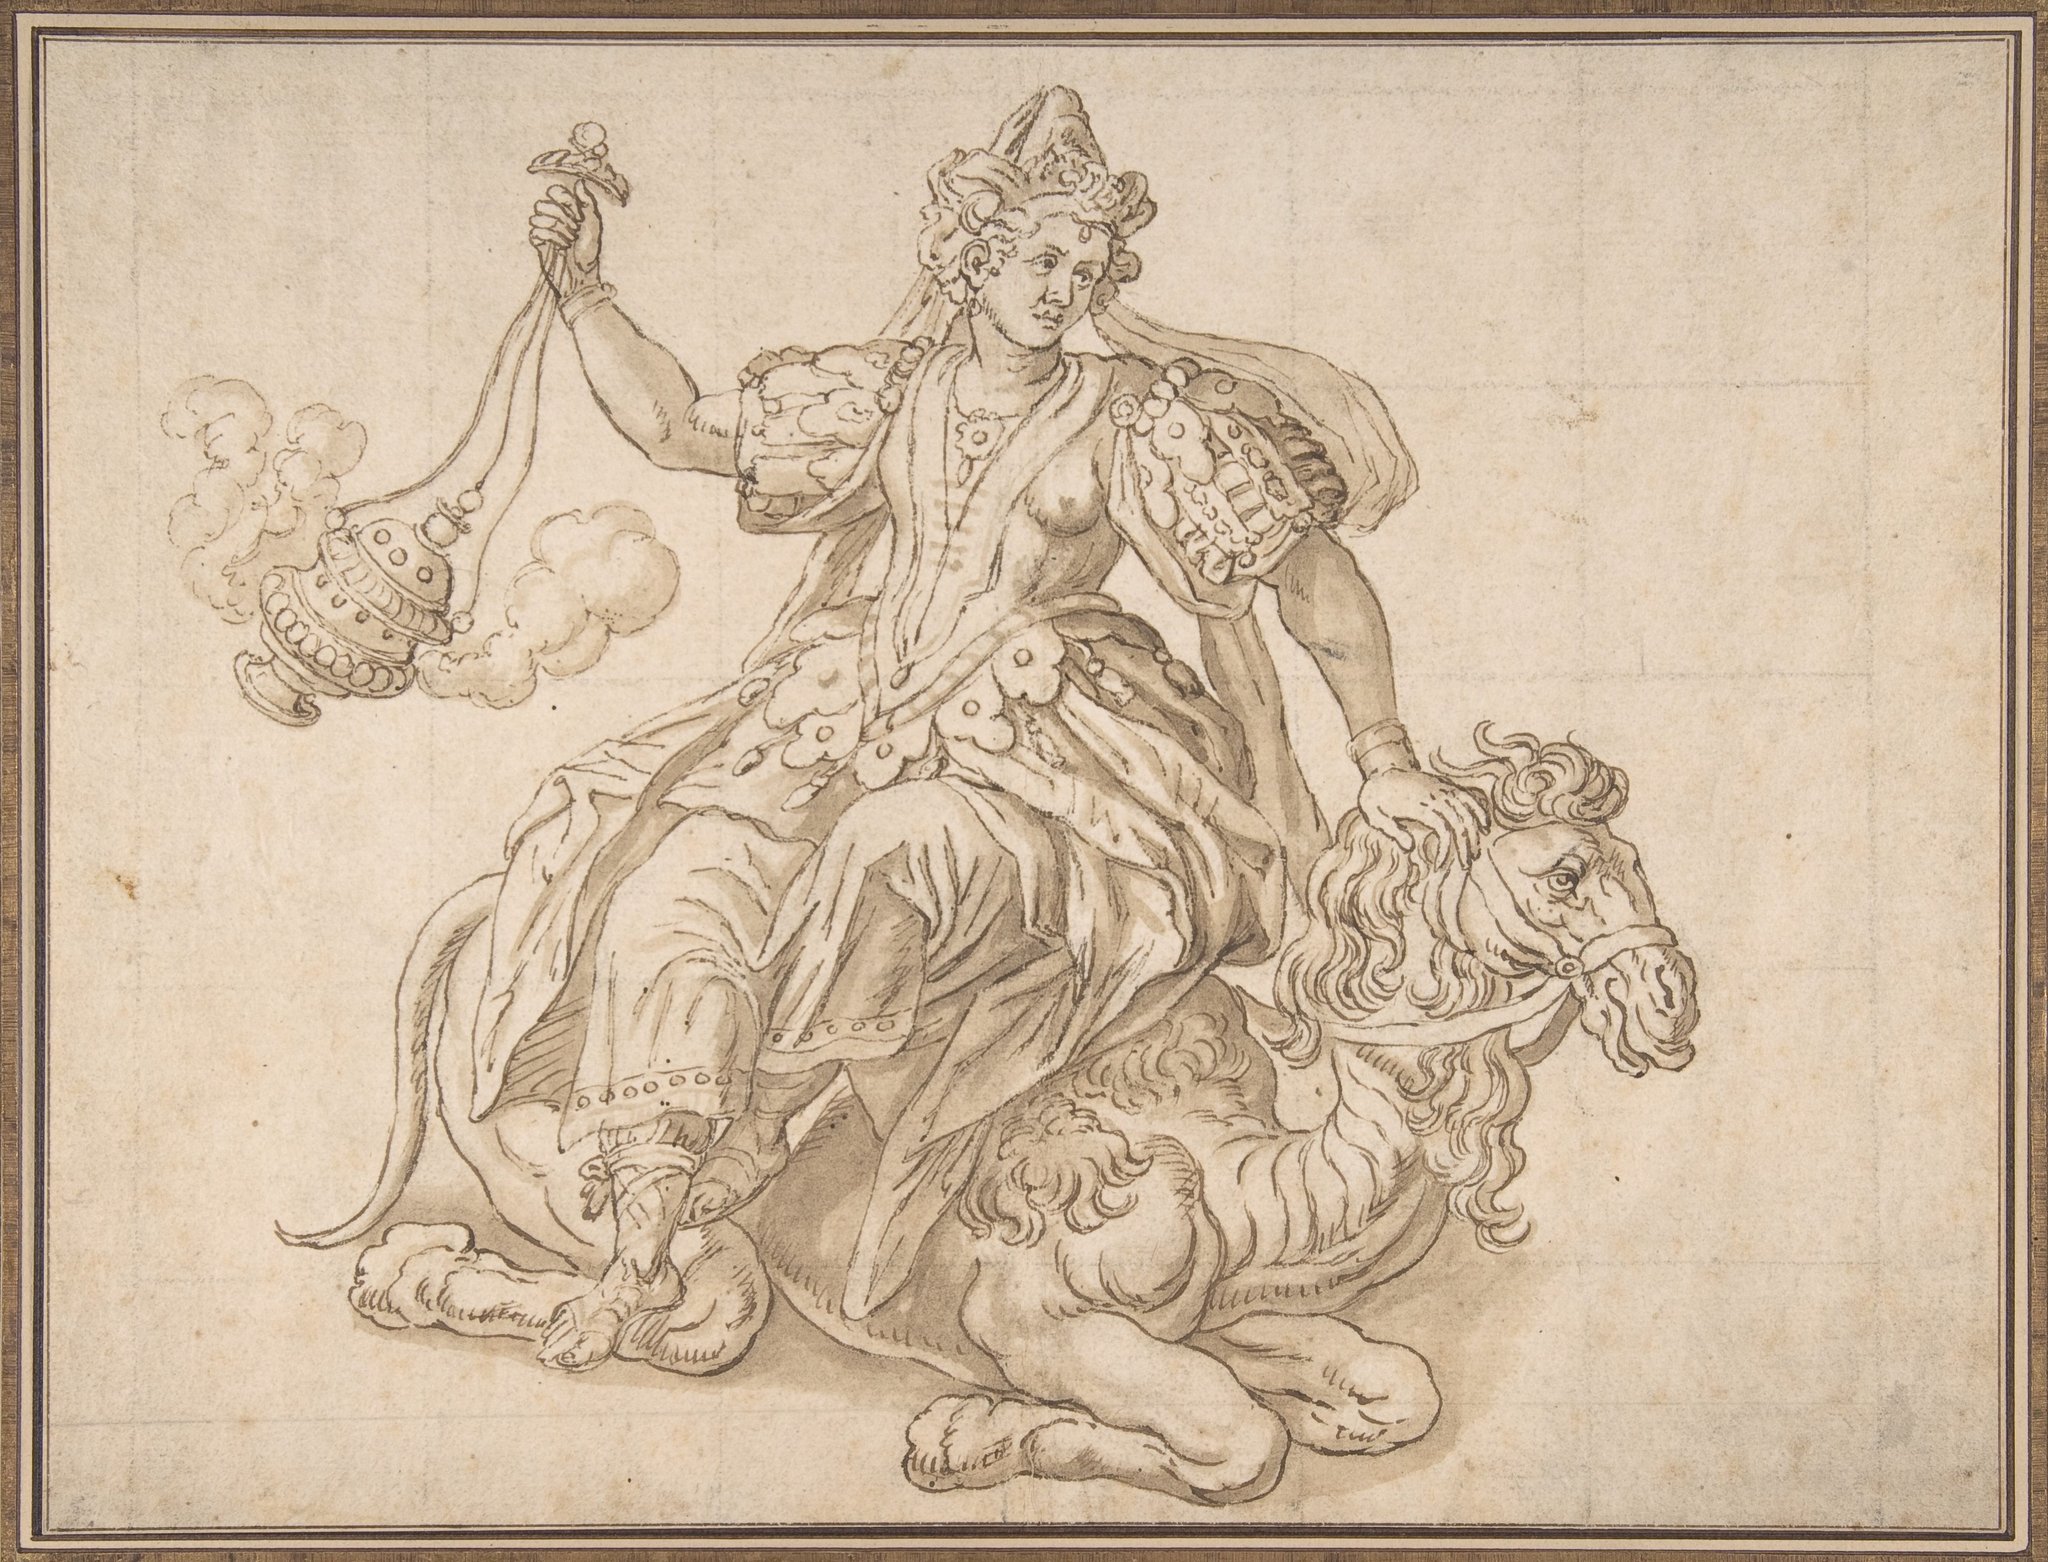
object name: drawing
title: Allegory of Asia, from "The Four Continents"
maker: anonymous, netherlandish, 16th century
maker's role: artist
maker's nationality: netherlandish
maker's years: 1500-1600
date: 1501-1600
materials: chalk, ink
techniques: brush, pen, drawing, wash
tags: women,horses,censers